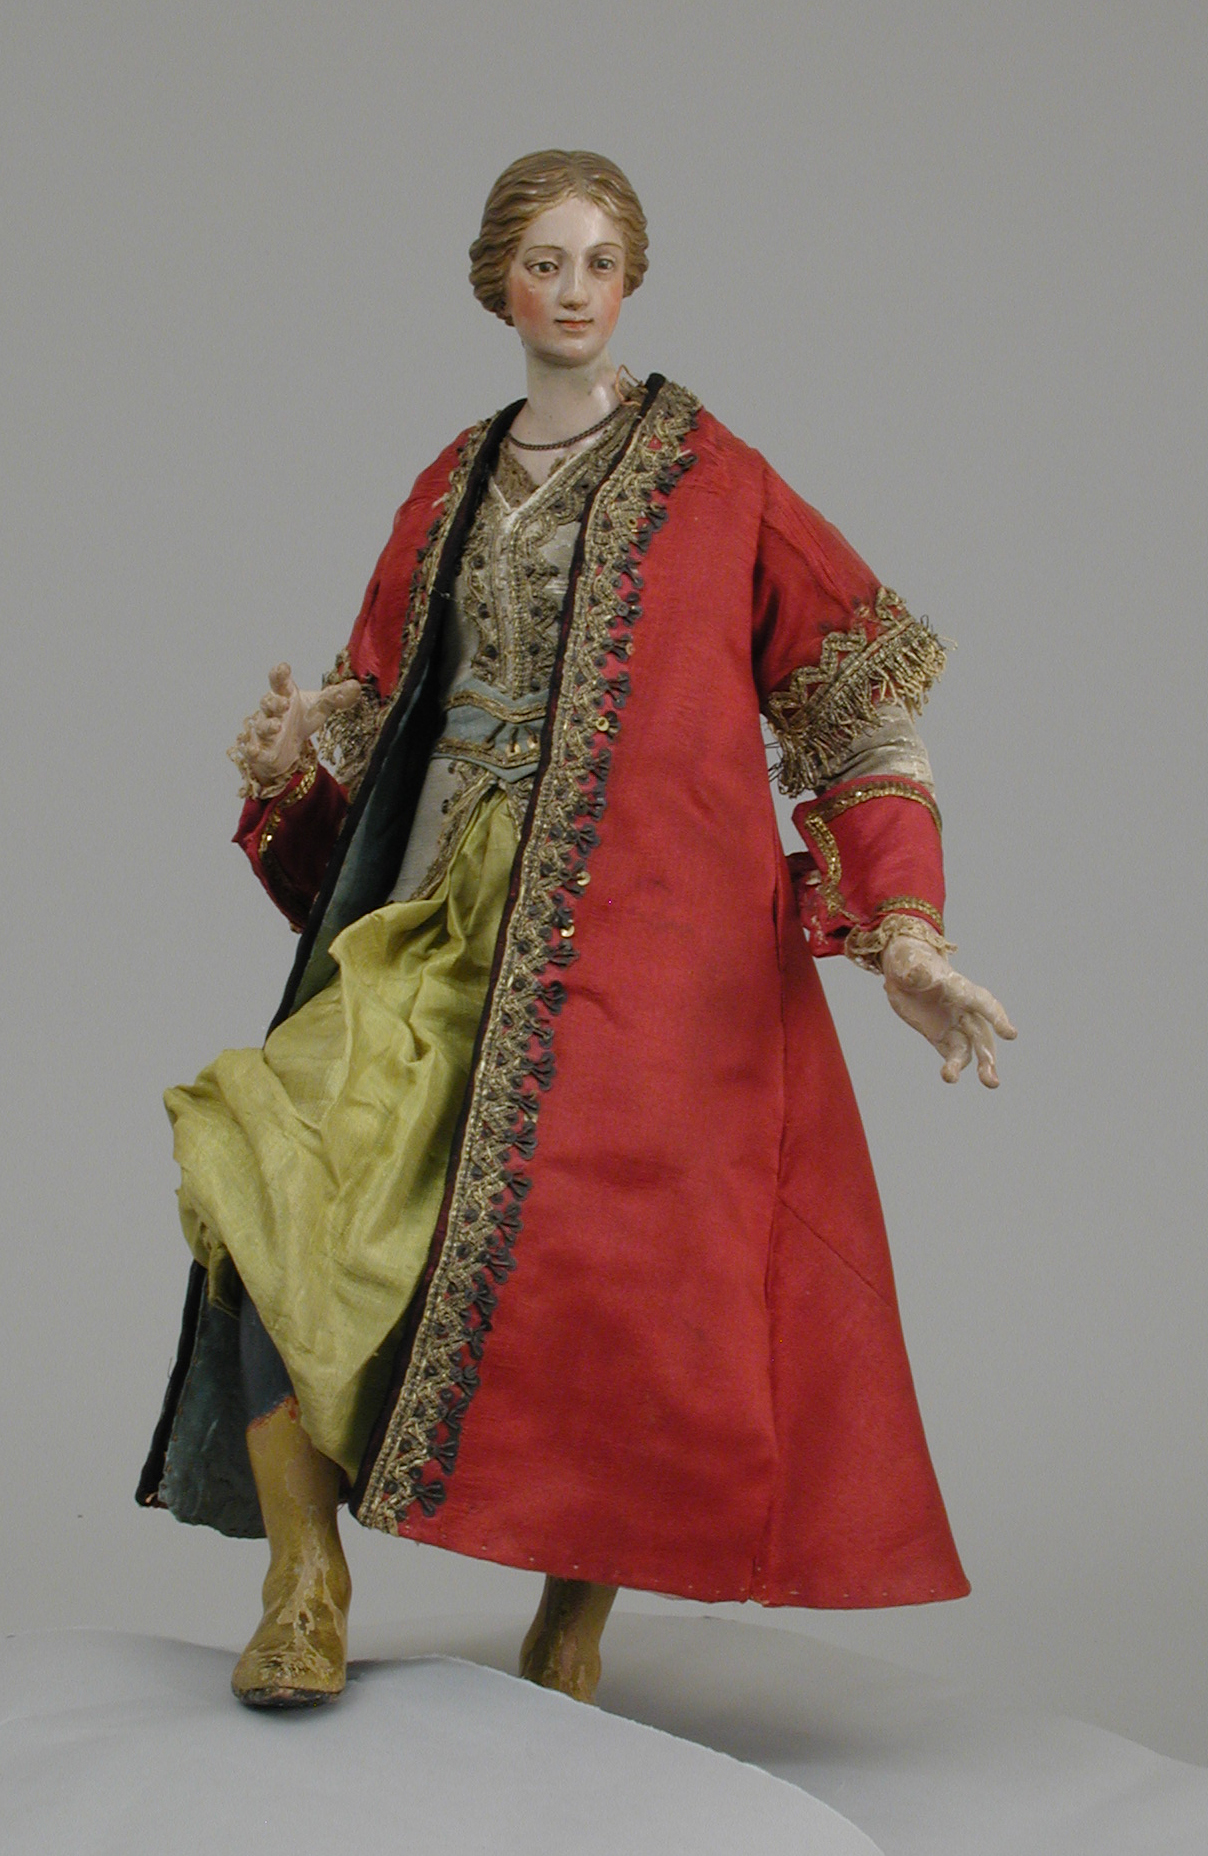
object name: crèche figure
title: Oriental woman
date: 1701-1900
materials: glass, metal thread, silk, terracotta, fiber, metal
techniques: polychrome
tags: women